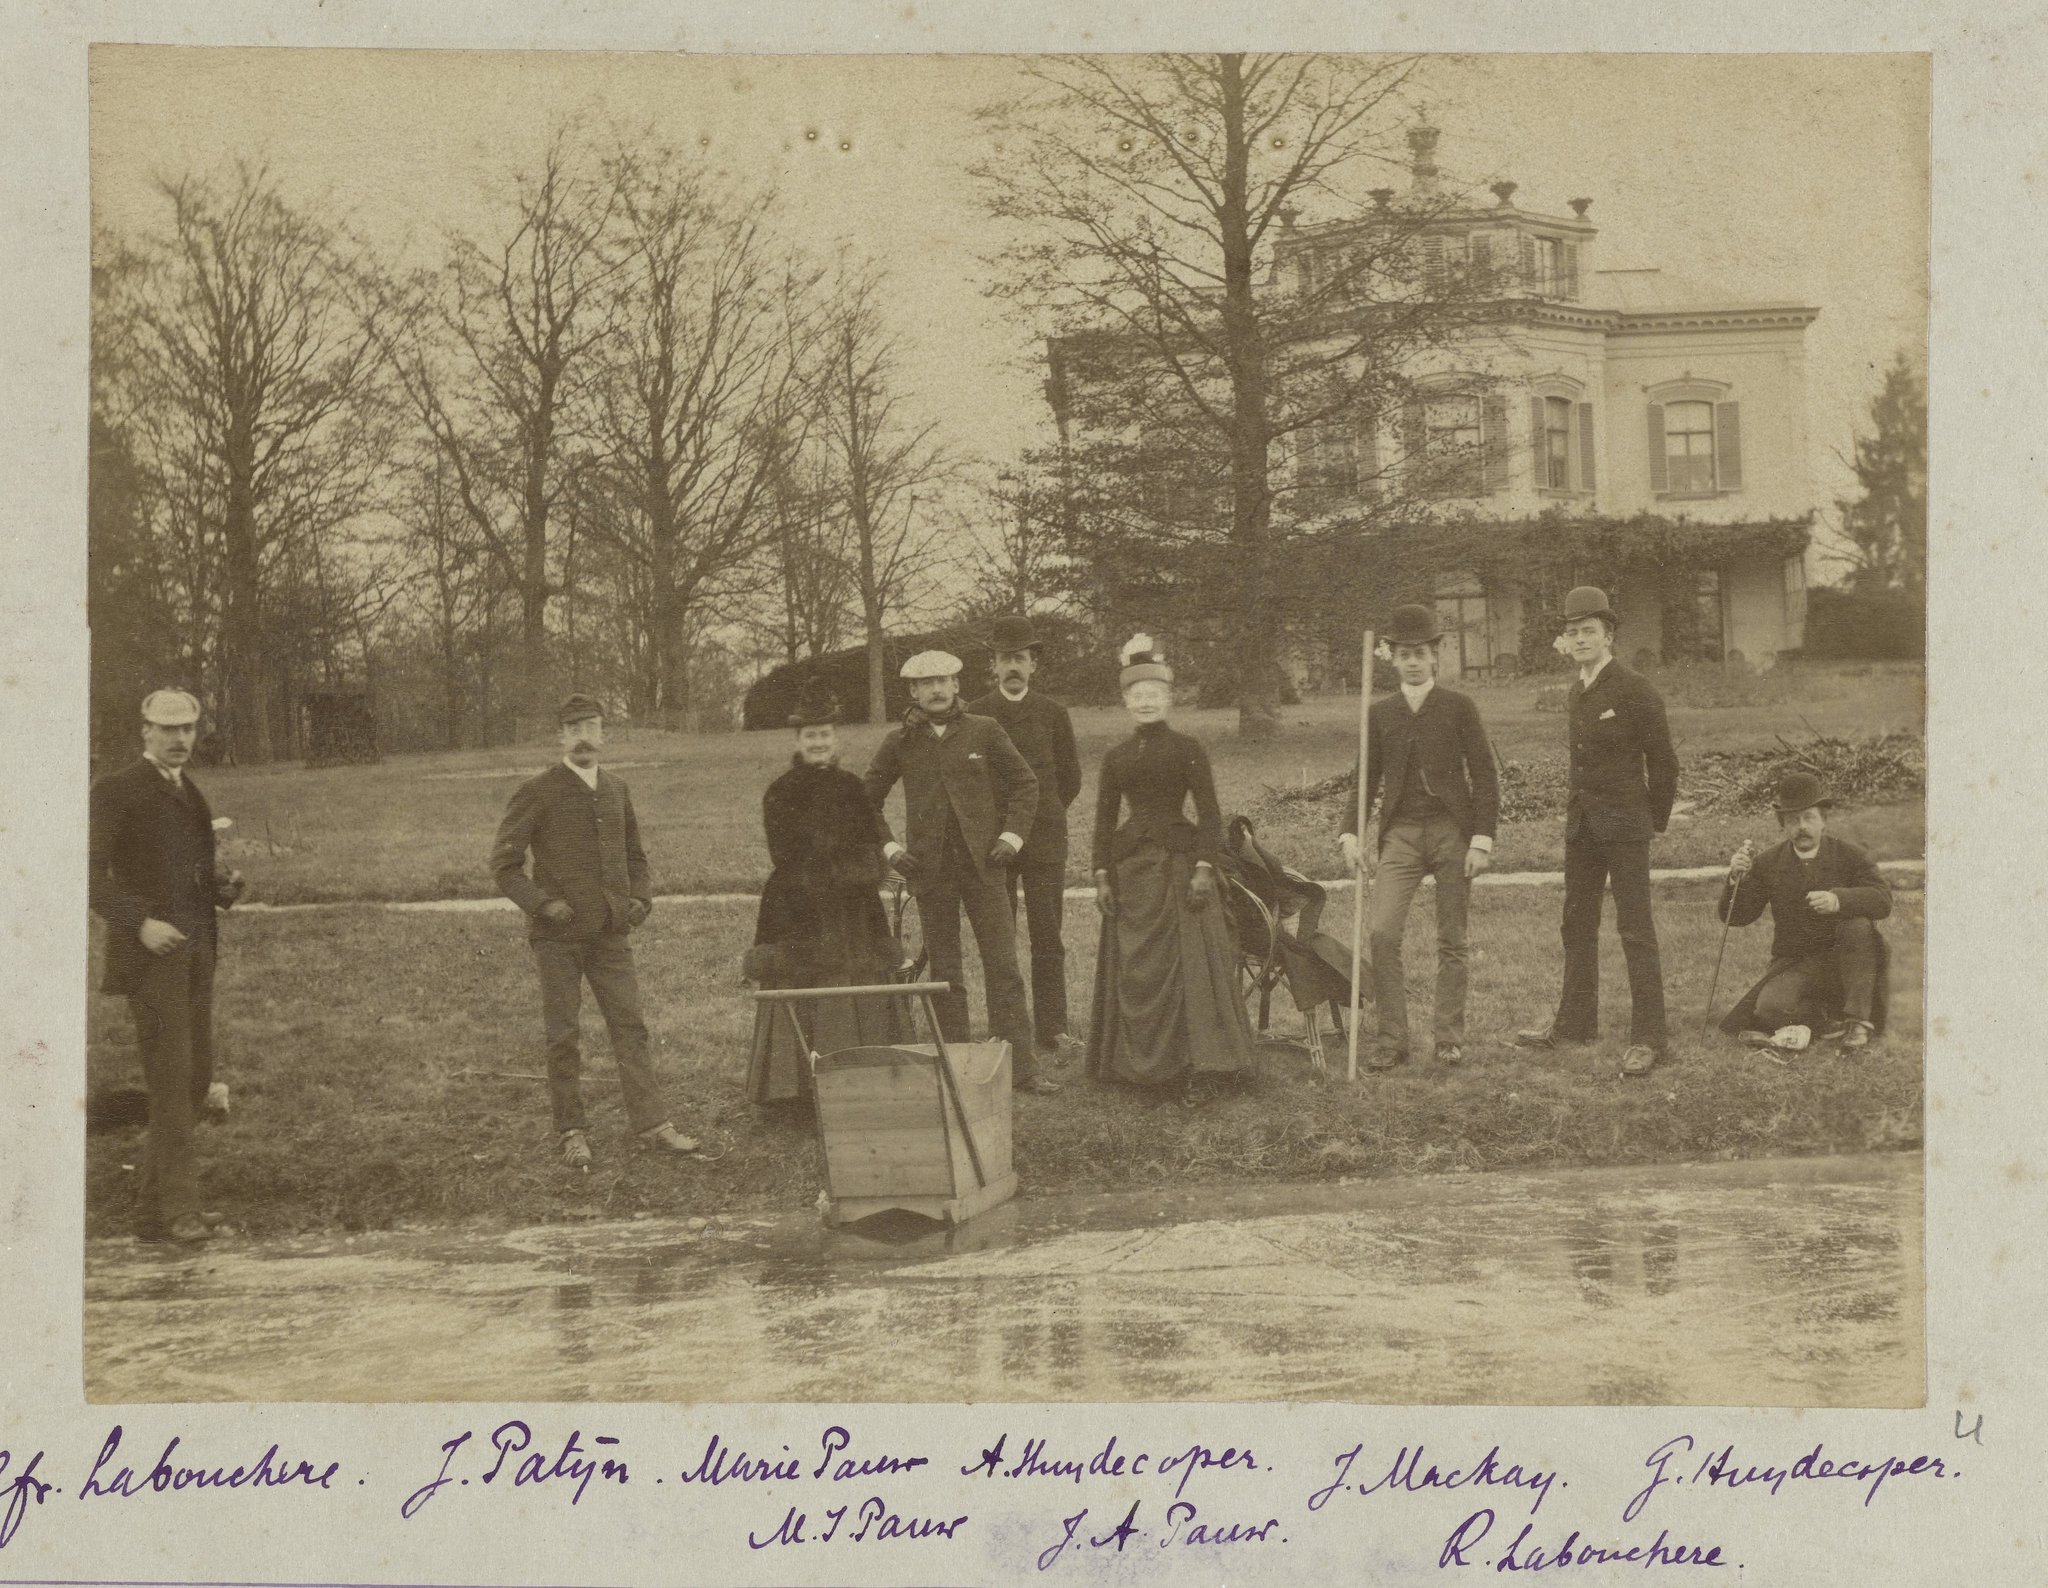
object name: photograph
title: Pages from the Album of the Photographer: Fun on the Ice, a Hunting Party, and a Self-portrait (lower right) with a Self-timer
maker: henry pauw van wieldrecht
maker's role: fotograaf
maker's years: 1863-1912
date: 1888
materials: paper, photographic support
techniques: albumen print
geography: netherlands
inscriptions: title: ‘Alfr. Labouchere. J. Patijn. Marie Pauw. A. Huydecoper. J. Mackay. G. Huydecoper. / M.J. Pauw J.A. Pauw. R. Labouchere. / Groep bij het ijs. Pavia 11/11. 1888.’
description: Onder op het albumblad geschreven: de foto geschreven: V.l.n.r.: Alfr. Labouchère, J. Patijn, Marie Pauw van Wieldrecht, Maarten Pauw van Wieldrecht, A. Huydecoper, A.J. (Jenny) Pauw van Wieldrecht, J. Mackay, R. Labouchère, G. Huydecoper.